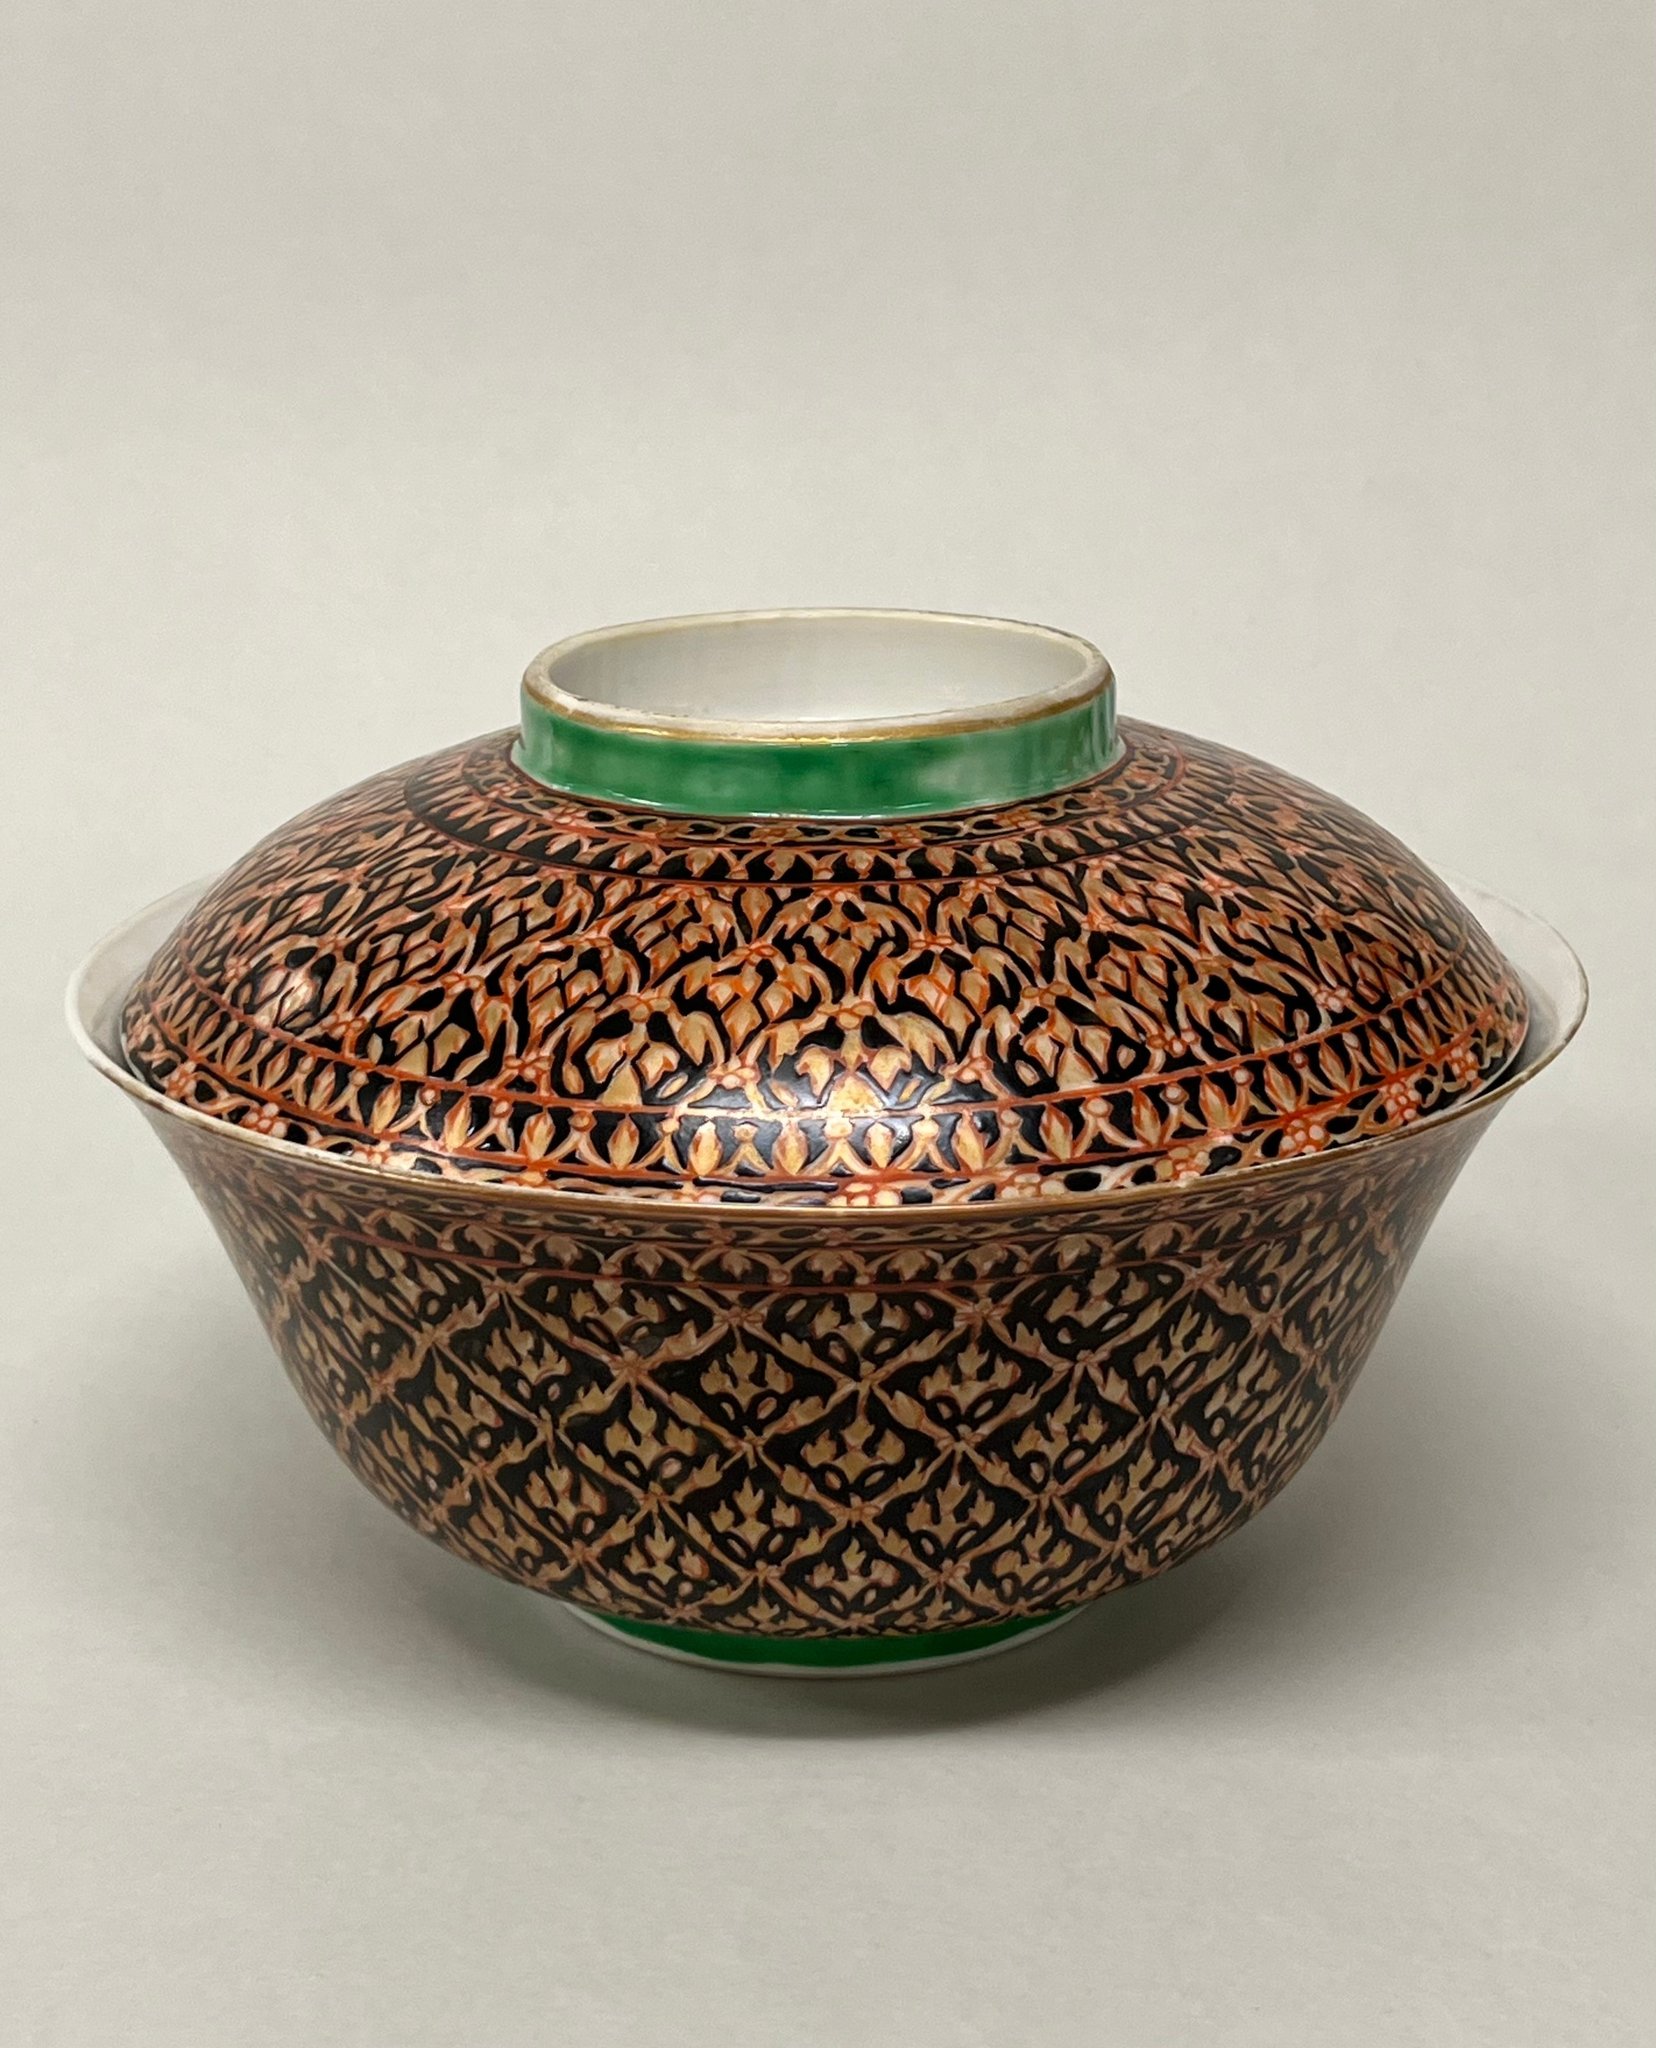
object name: covered bowl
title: Covered bowl with floral patterns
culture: chinese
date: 1801-1900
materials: enamel, porcelain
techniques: overglaze, painting, polychrome